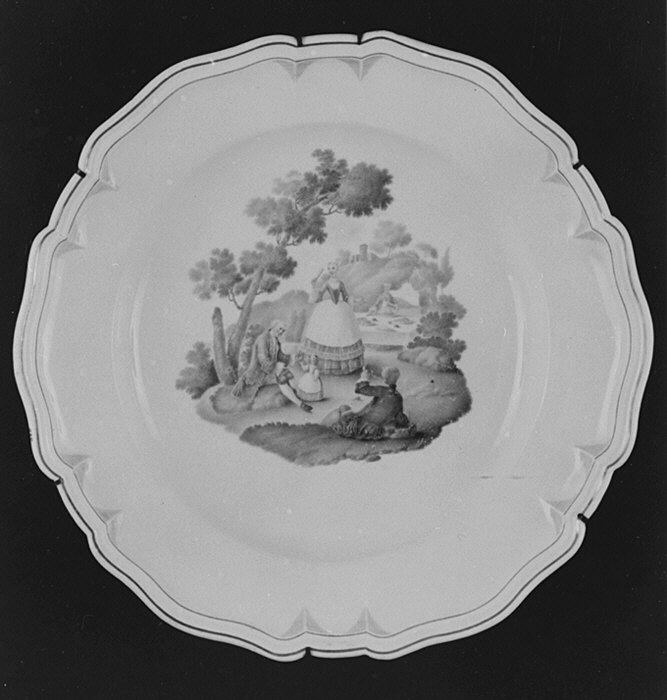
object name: plate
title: Hexafoil plate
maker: real fabrica de buen retiro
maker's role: factory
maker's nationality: spanish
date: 1765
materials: soft paste porcelain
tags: men,women,trees